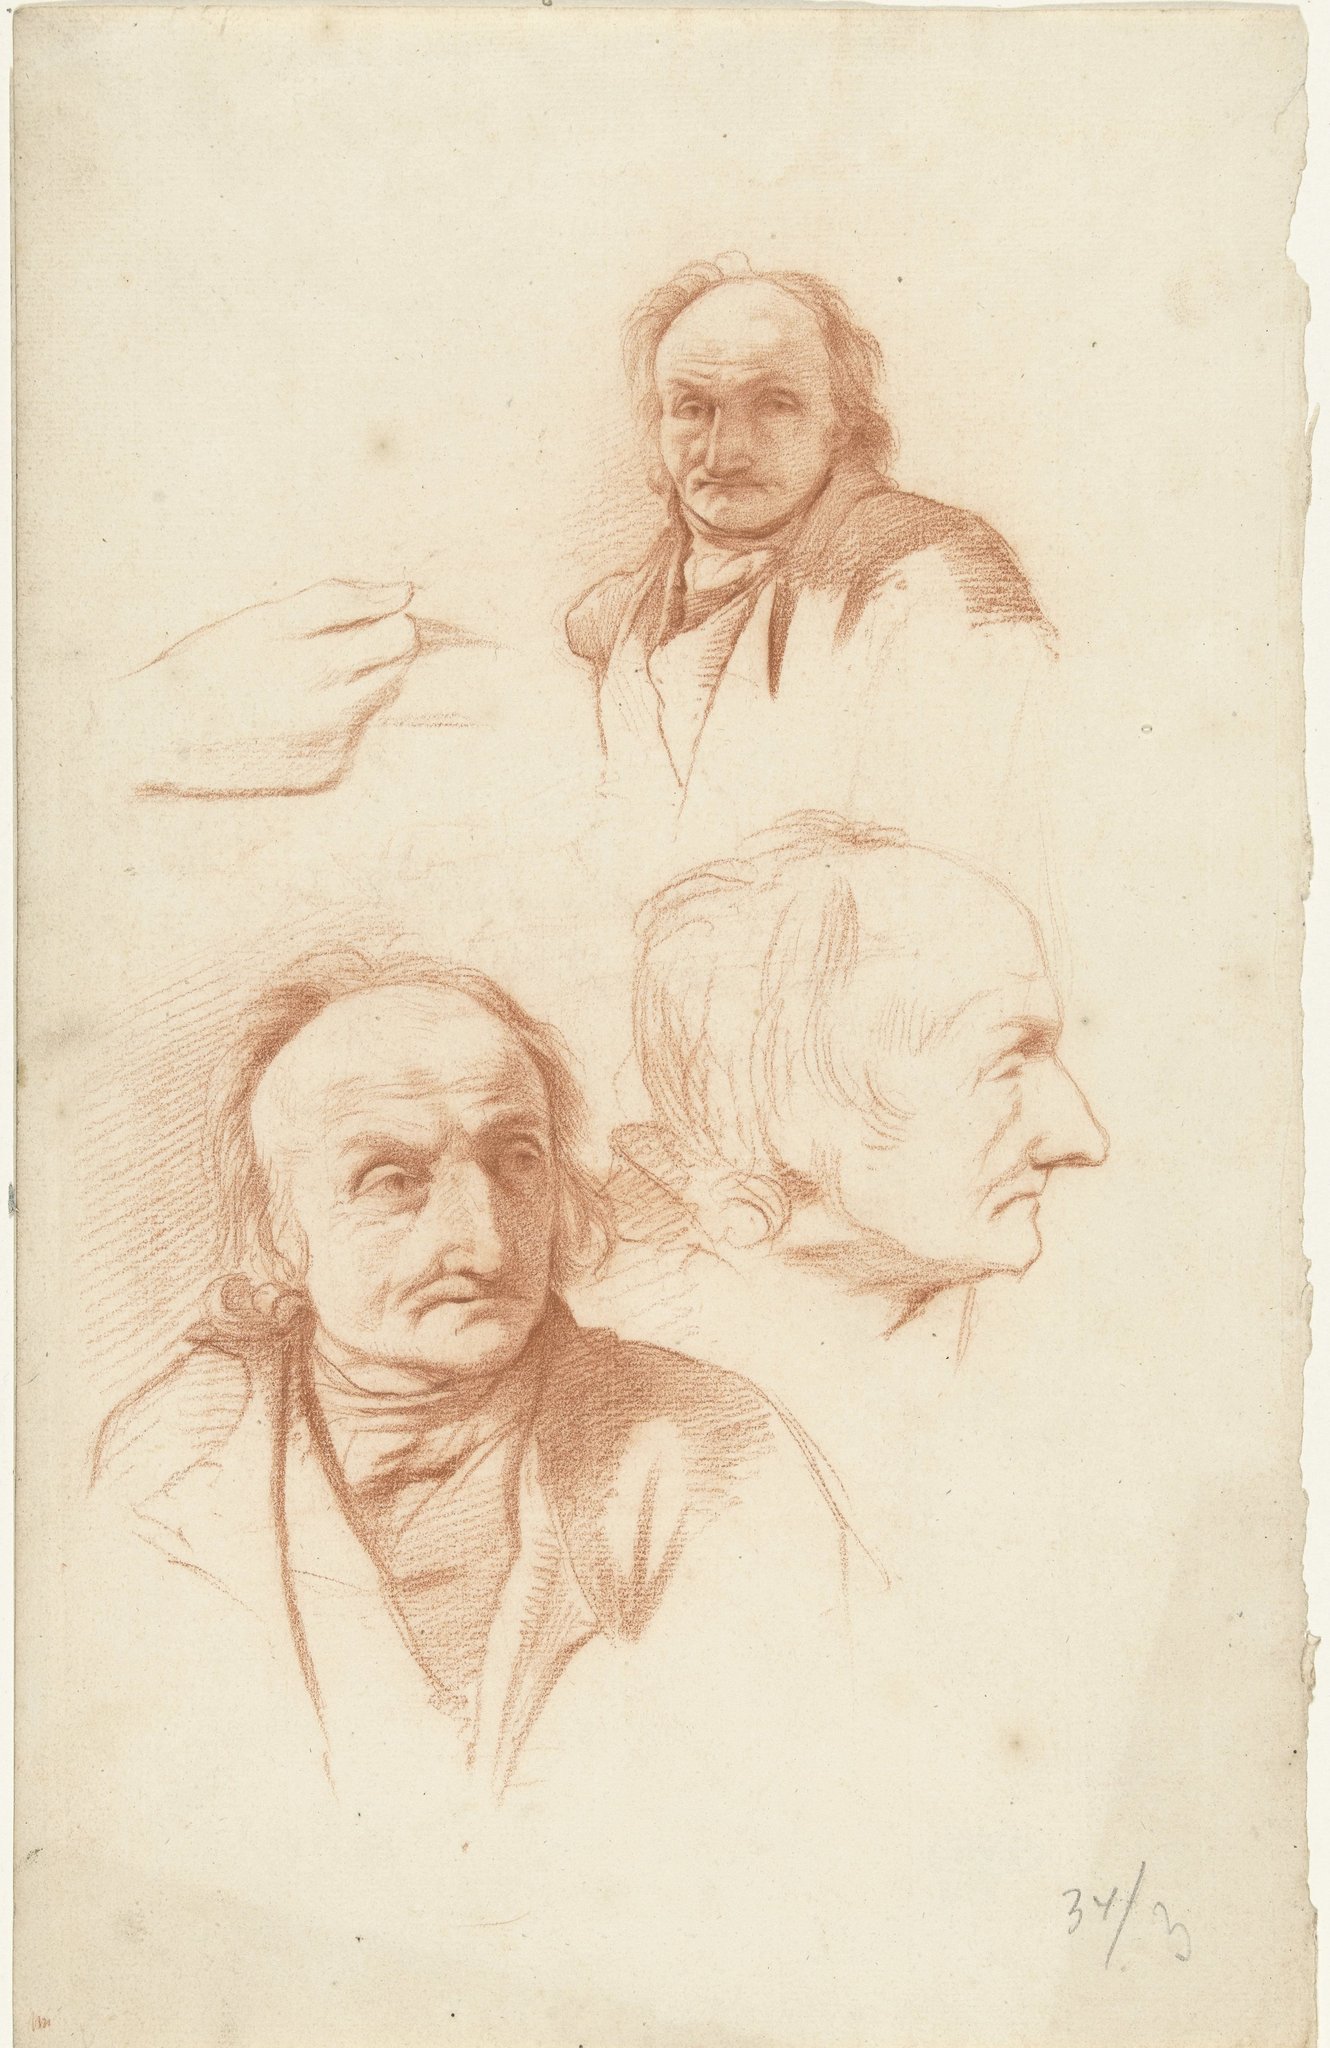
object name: drawing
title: Drie studies van het hoofd van een oude man en een hand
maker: abraham johannes ruytenschildt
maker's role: draughtsman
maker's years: 1778-1841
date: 1812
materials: chalk, paper